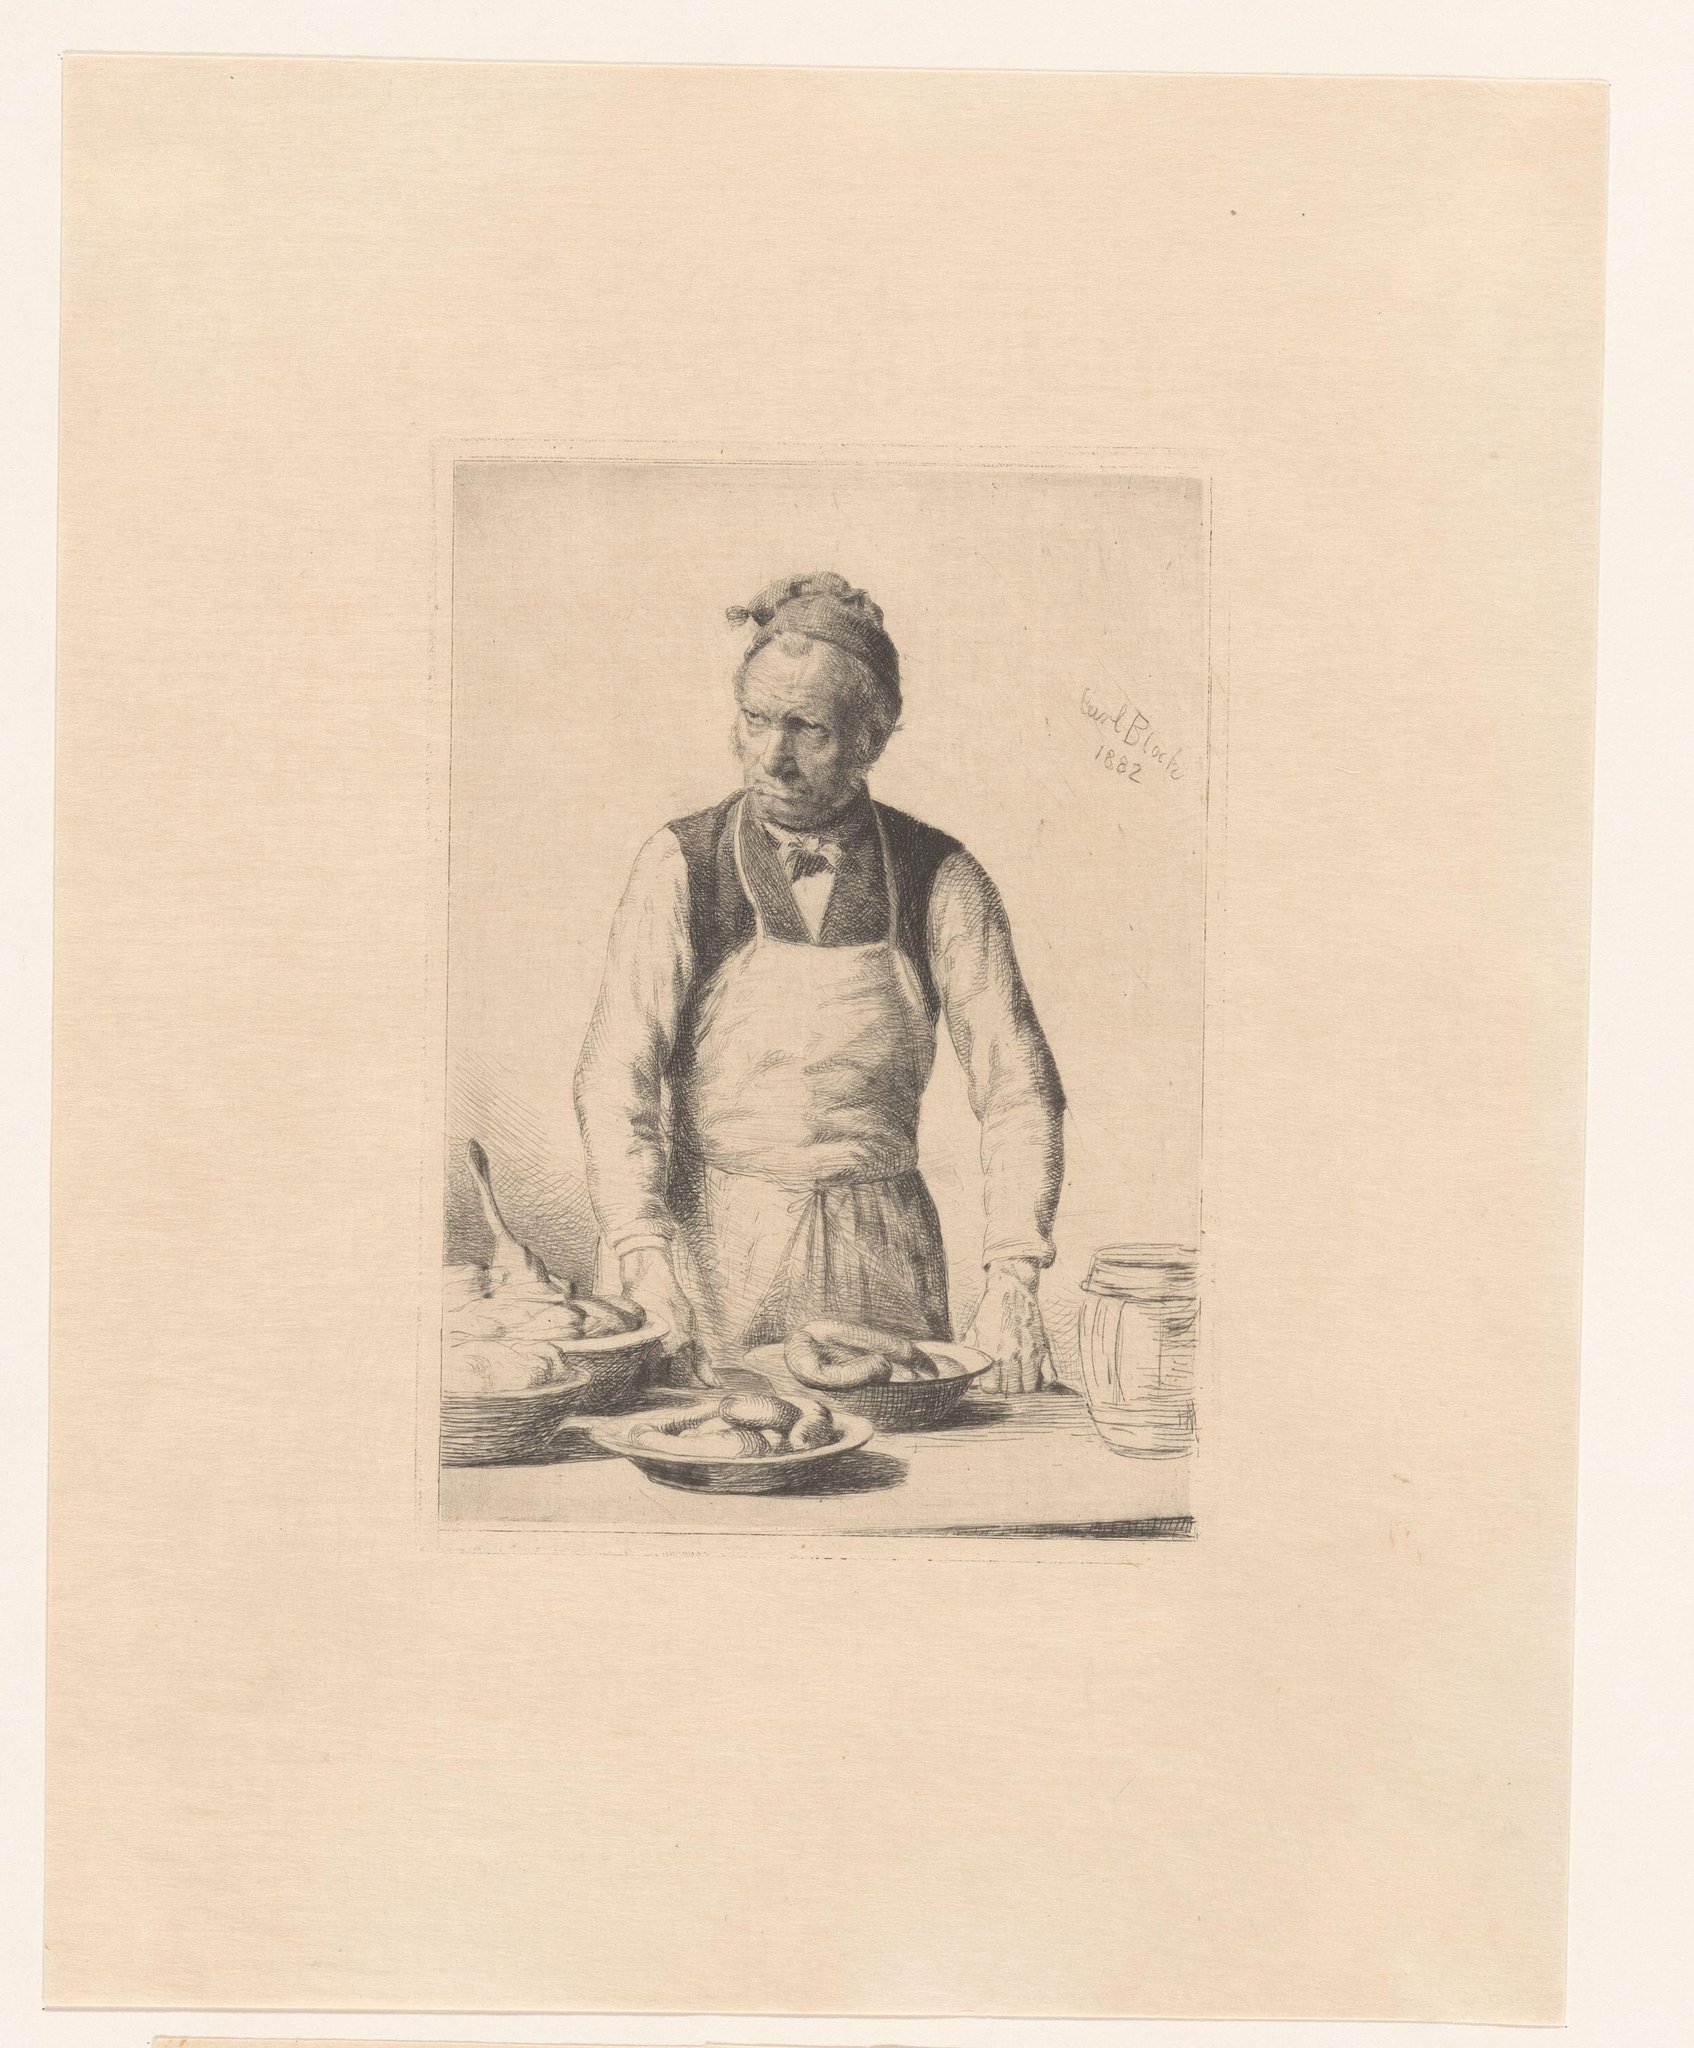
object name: print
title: Worstmaker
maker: carl bloch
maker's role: print maker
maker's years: 1834-1890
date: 1882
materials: paper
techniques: drypoint, etching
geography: scandinavia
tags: butcher, slaughterman, sausage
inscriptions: signature and date: ‘r.b., naast het hoofd van de man, gesigneerd en gedateerd: Carl Bloch 1882’, collector's mark: Lugt 2228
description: Worstmaker, staand achter zijn werktafel. Op de tafel twee schalen met worsten, twee schalen met ander vlees en een glazen pot. De worstmaker draagt een schort en heeft een mutsje op zijn hoofd.